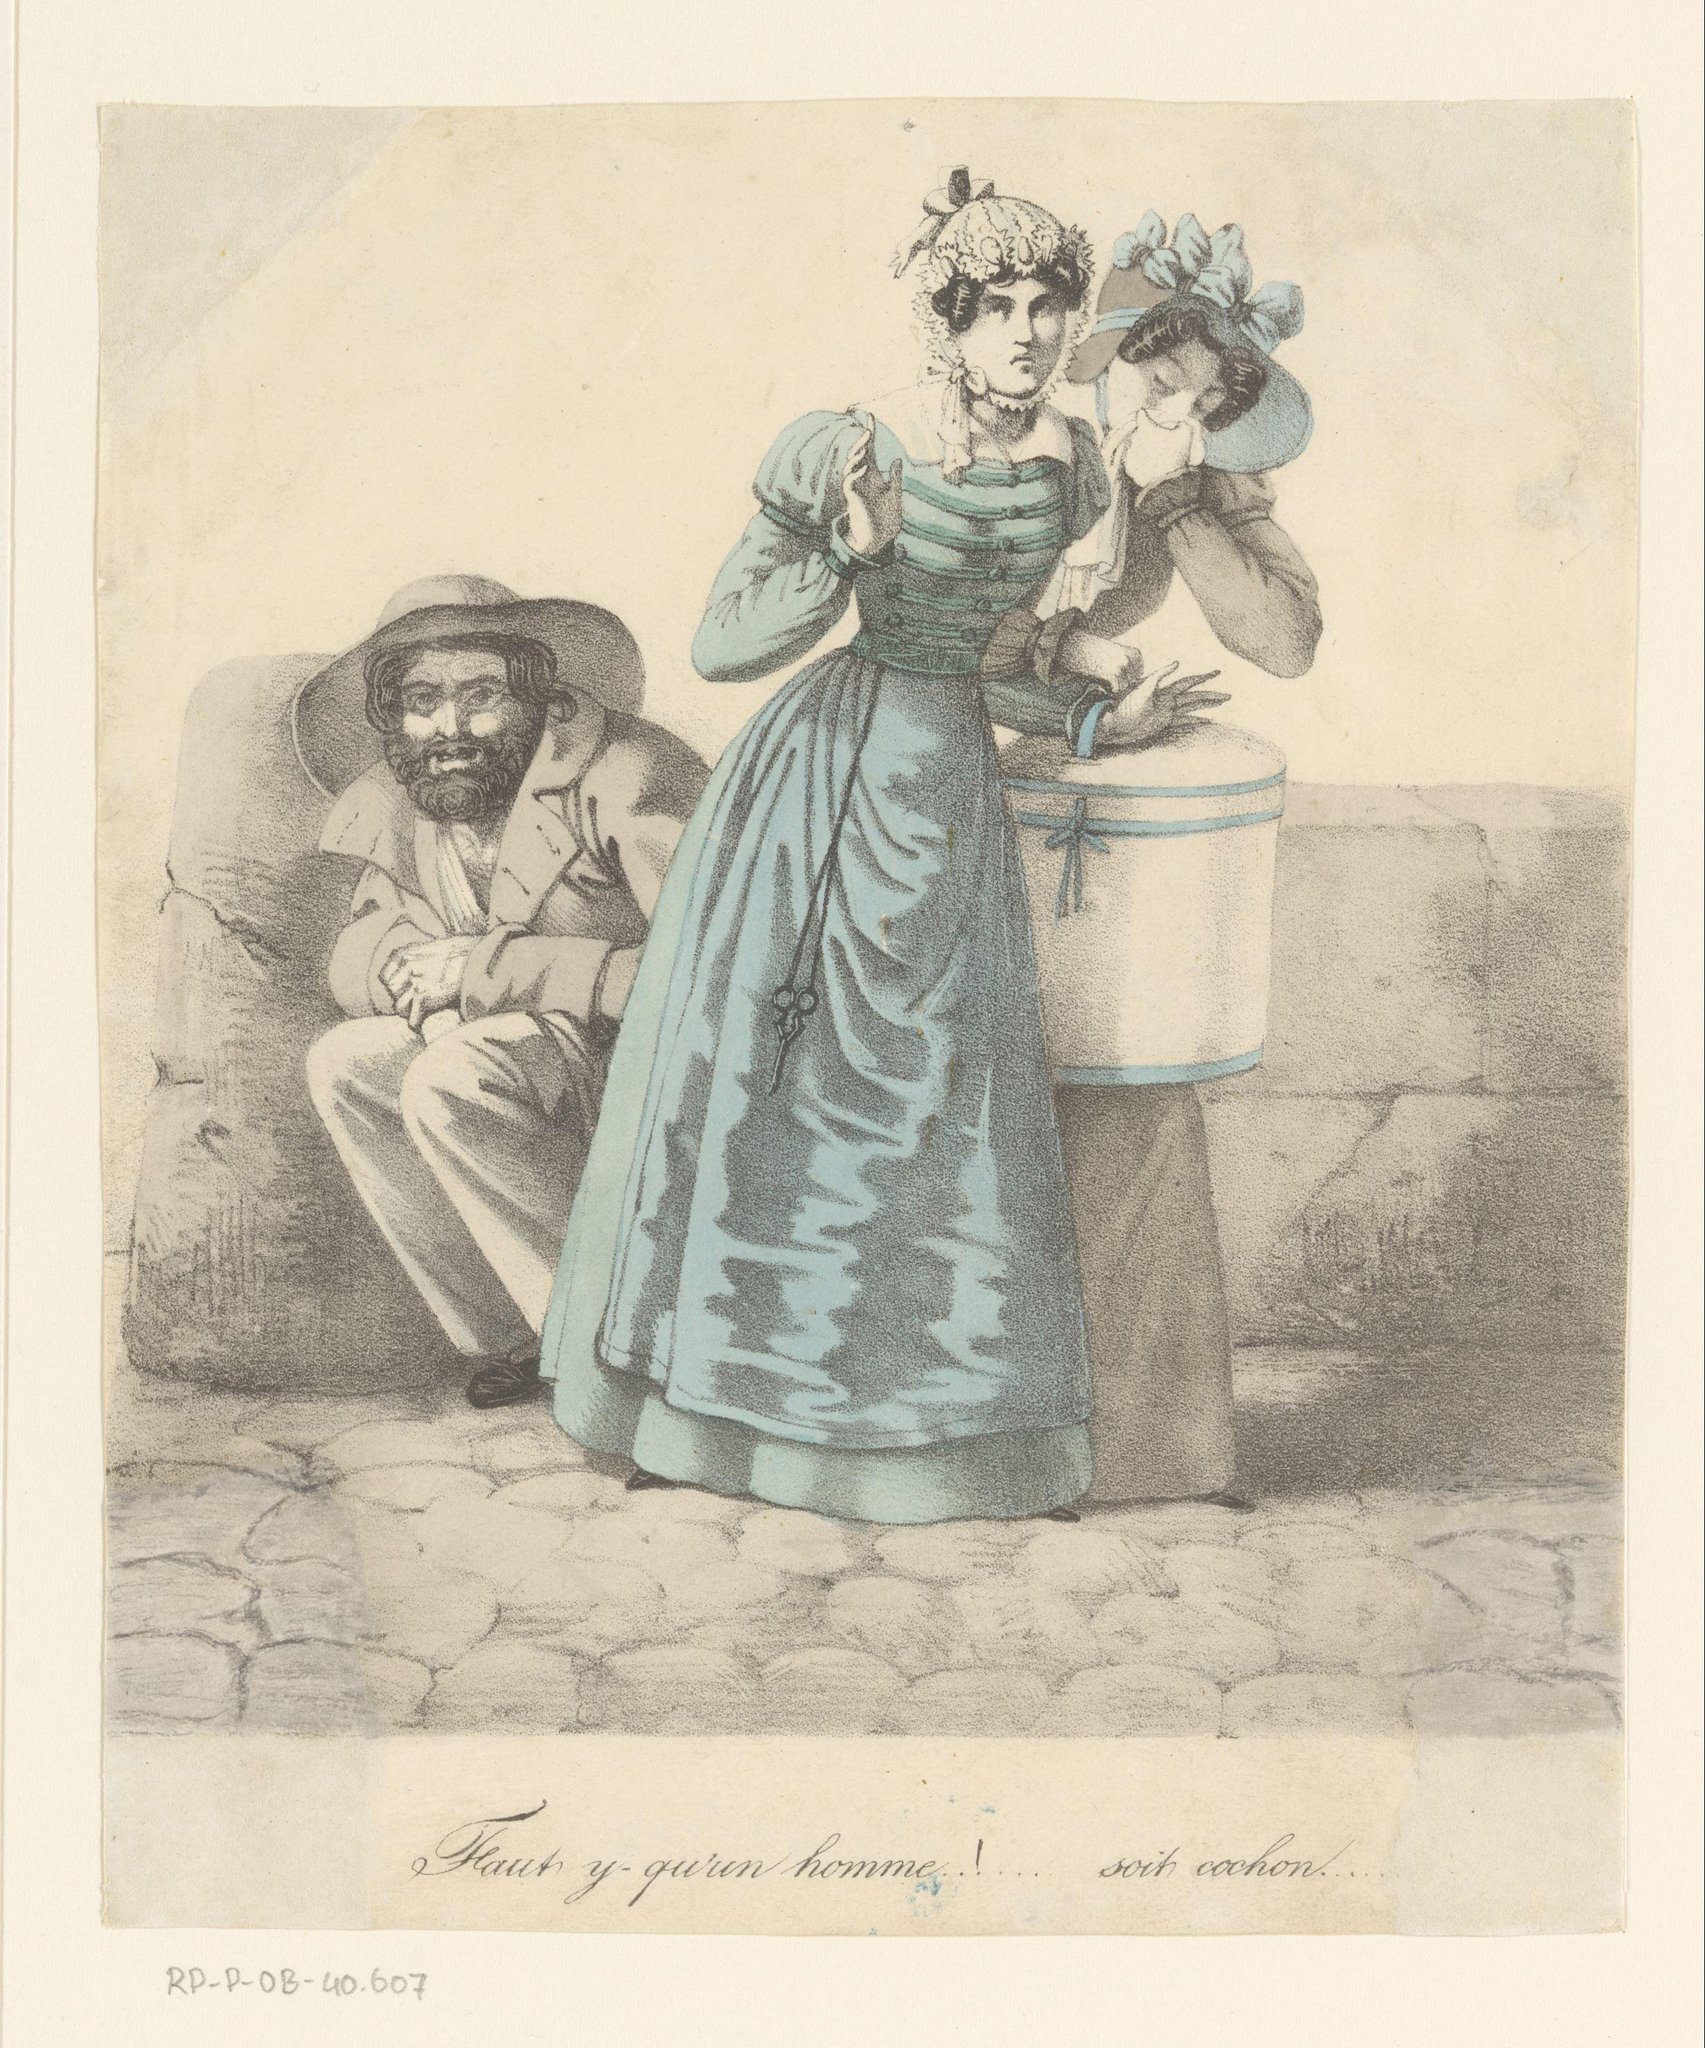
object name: print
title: Faut y-qu'un homme..!... soit cochon....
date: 1824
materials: ink, paper, pencil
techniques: brush, lithograph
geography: paris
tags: adult woman, disagreeable, repellent smell, adult man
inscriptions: collector's mark: Lugt 2228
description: Prent is in de hoeken gerestaureerd. Op een niet gerestaureerd exemplaar van de U.S. National Library of Medicine staat linksonder 'D.N.3.', onduidelijk of dit een signatuur is. Ook zijn daarop de mogelijke drukker en uitgever te zien.